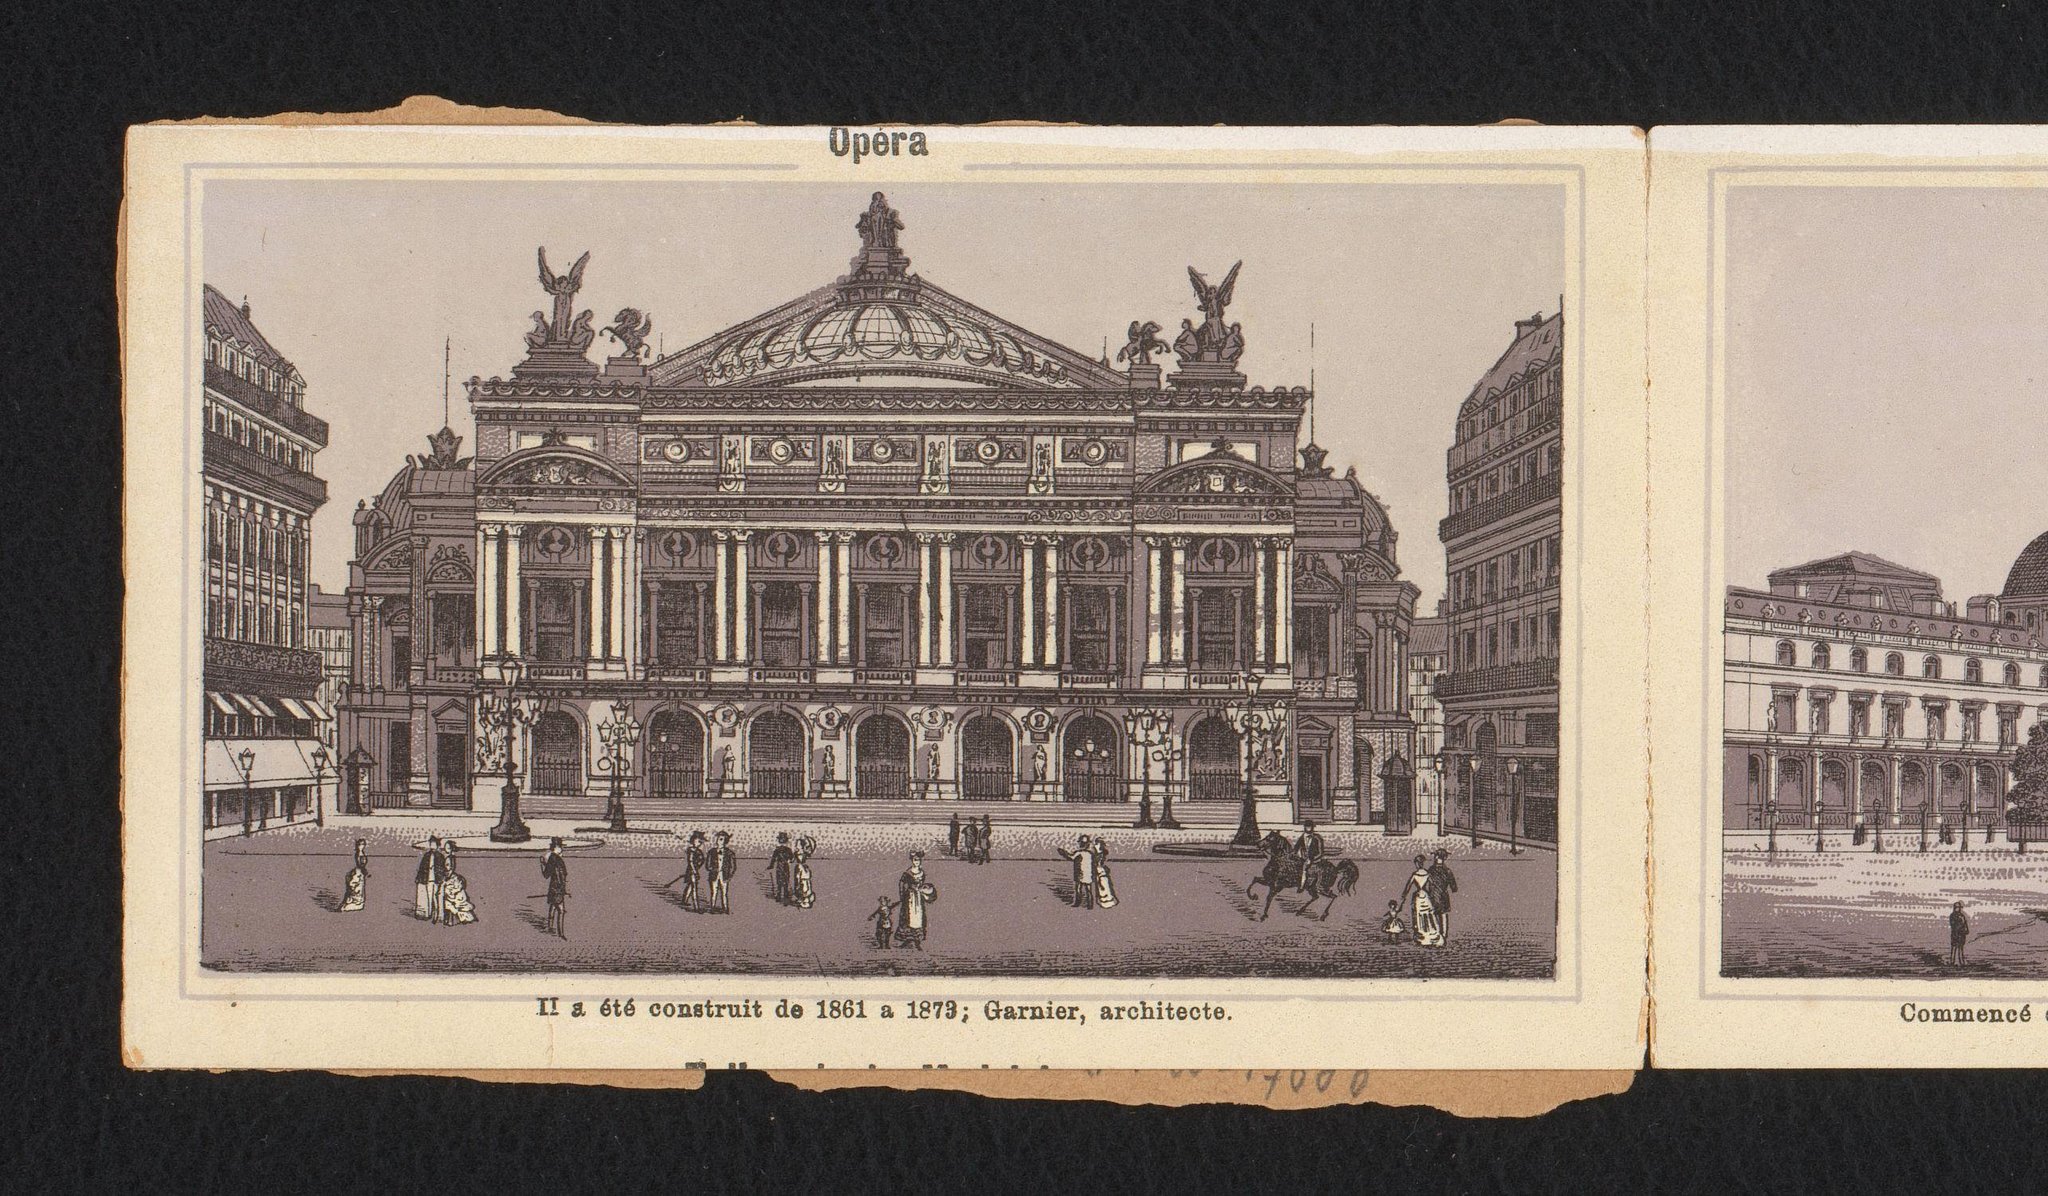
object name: print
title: Opéra. Il a été construit a 1873; Garnier, architecte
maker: Anonymous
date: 1890-1910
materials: cardboard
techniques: lithograph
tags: square, place, circus, etc. (+ city(-scape) with figures, staffage), opera house